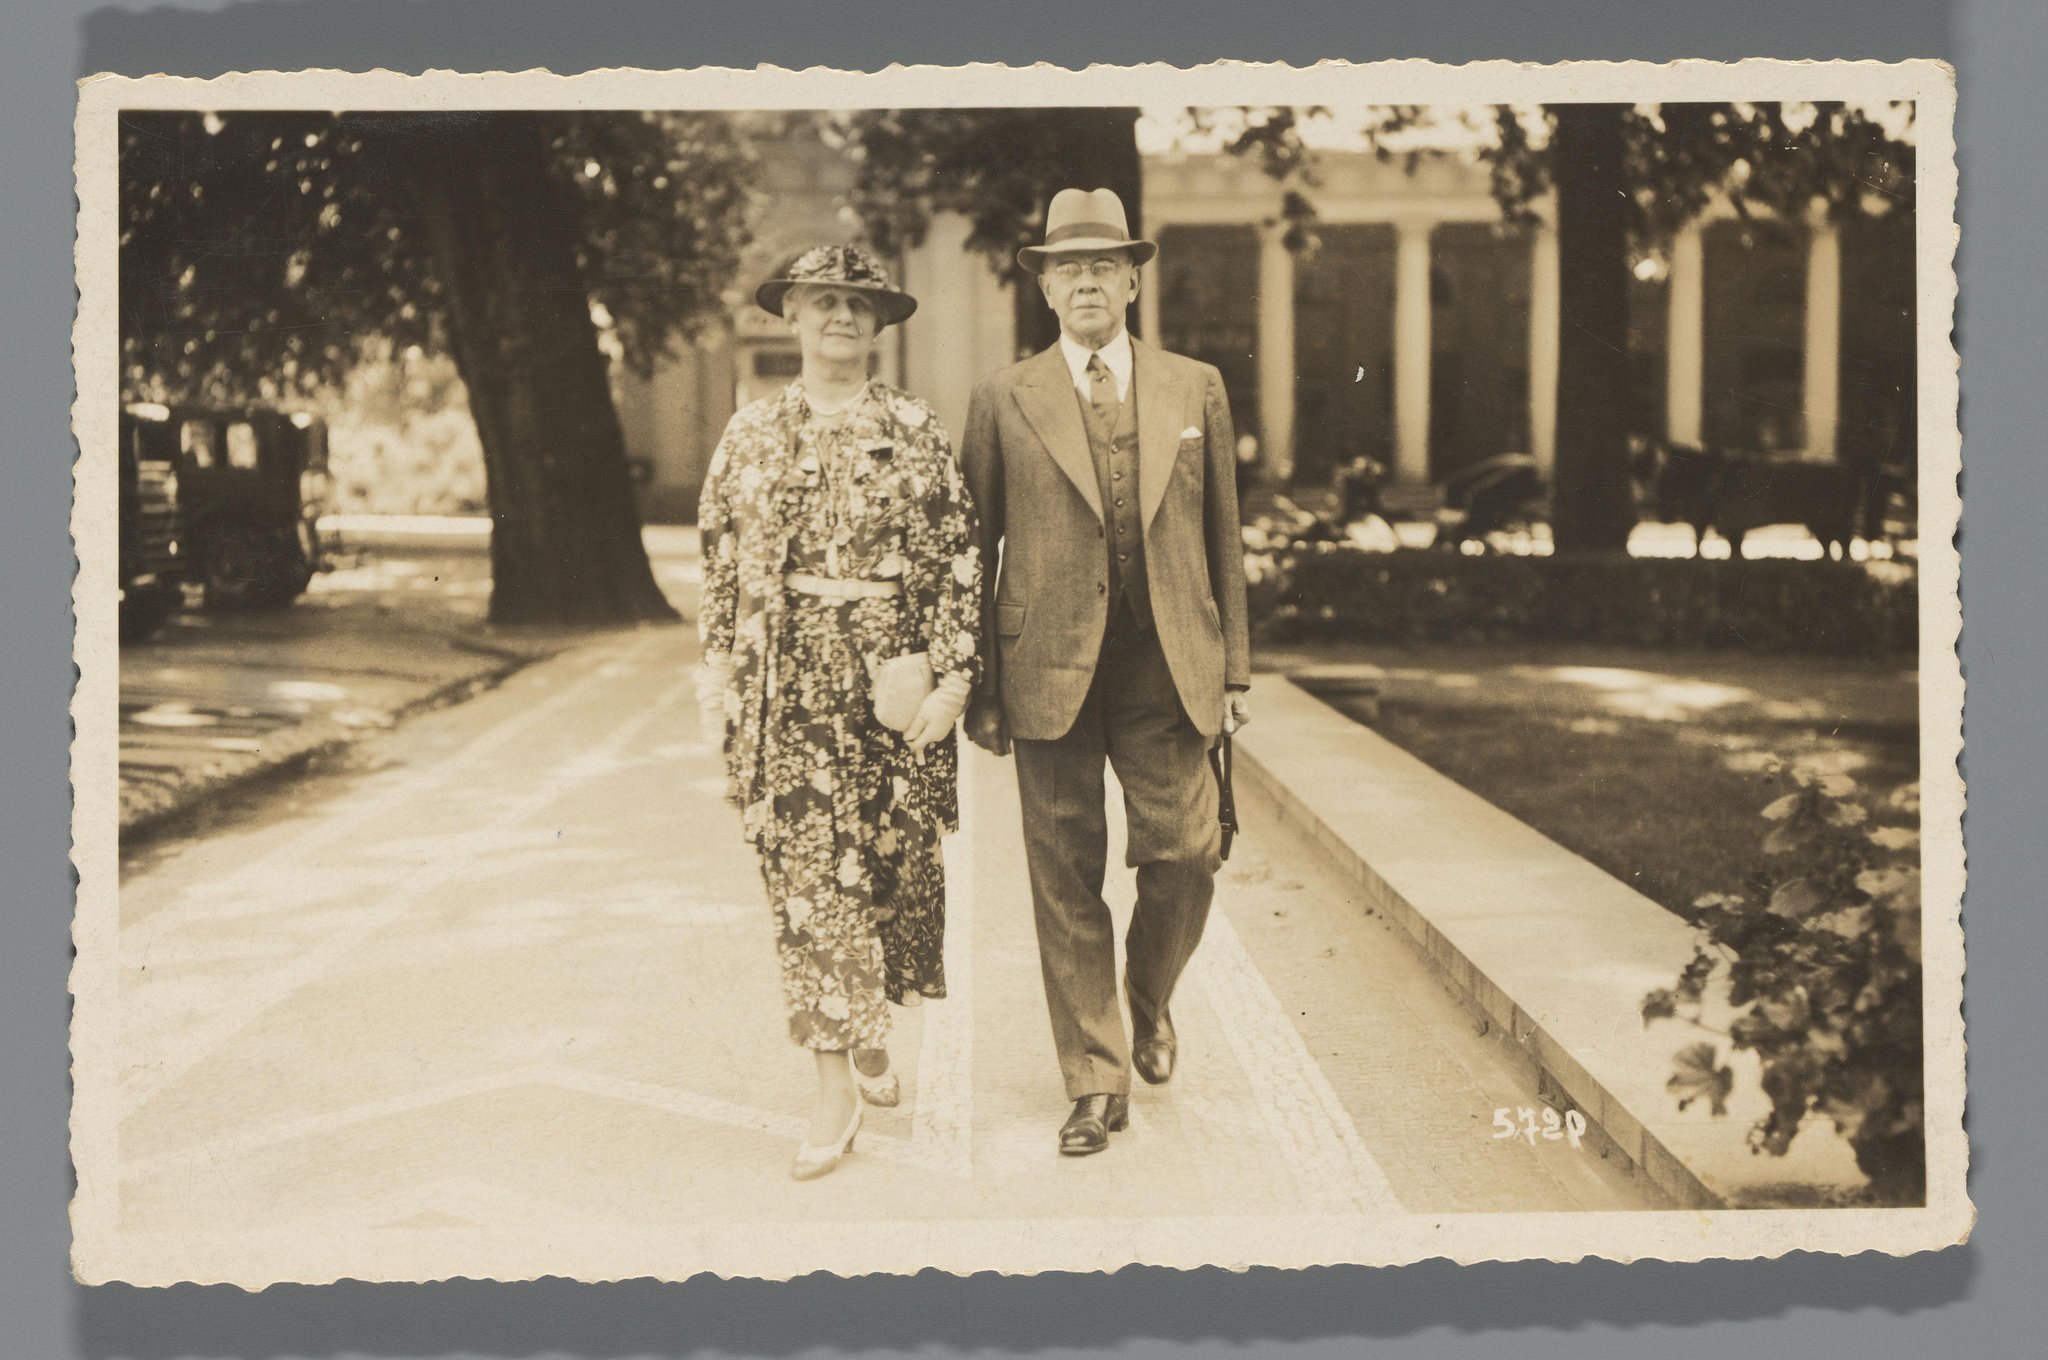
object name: photograph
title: Portret van Line en Hendrik Herman van den Berg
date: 1937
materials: photographic support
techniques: photography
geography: wiesbaden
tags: batavia, amsterdam, hendrik herman van den berg, the hague, caroline louise van den berg-van den berg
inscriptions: stamp, name: ‘Foto Kukuk, Wiesbaden, Wilhelmstrasse 55 Tel. 21...’, inscription, number: ‘5729’, date: ‘1937’, seal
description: Line en Hendrik Herman van den Berg wandelend in Wiesbaden.